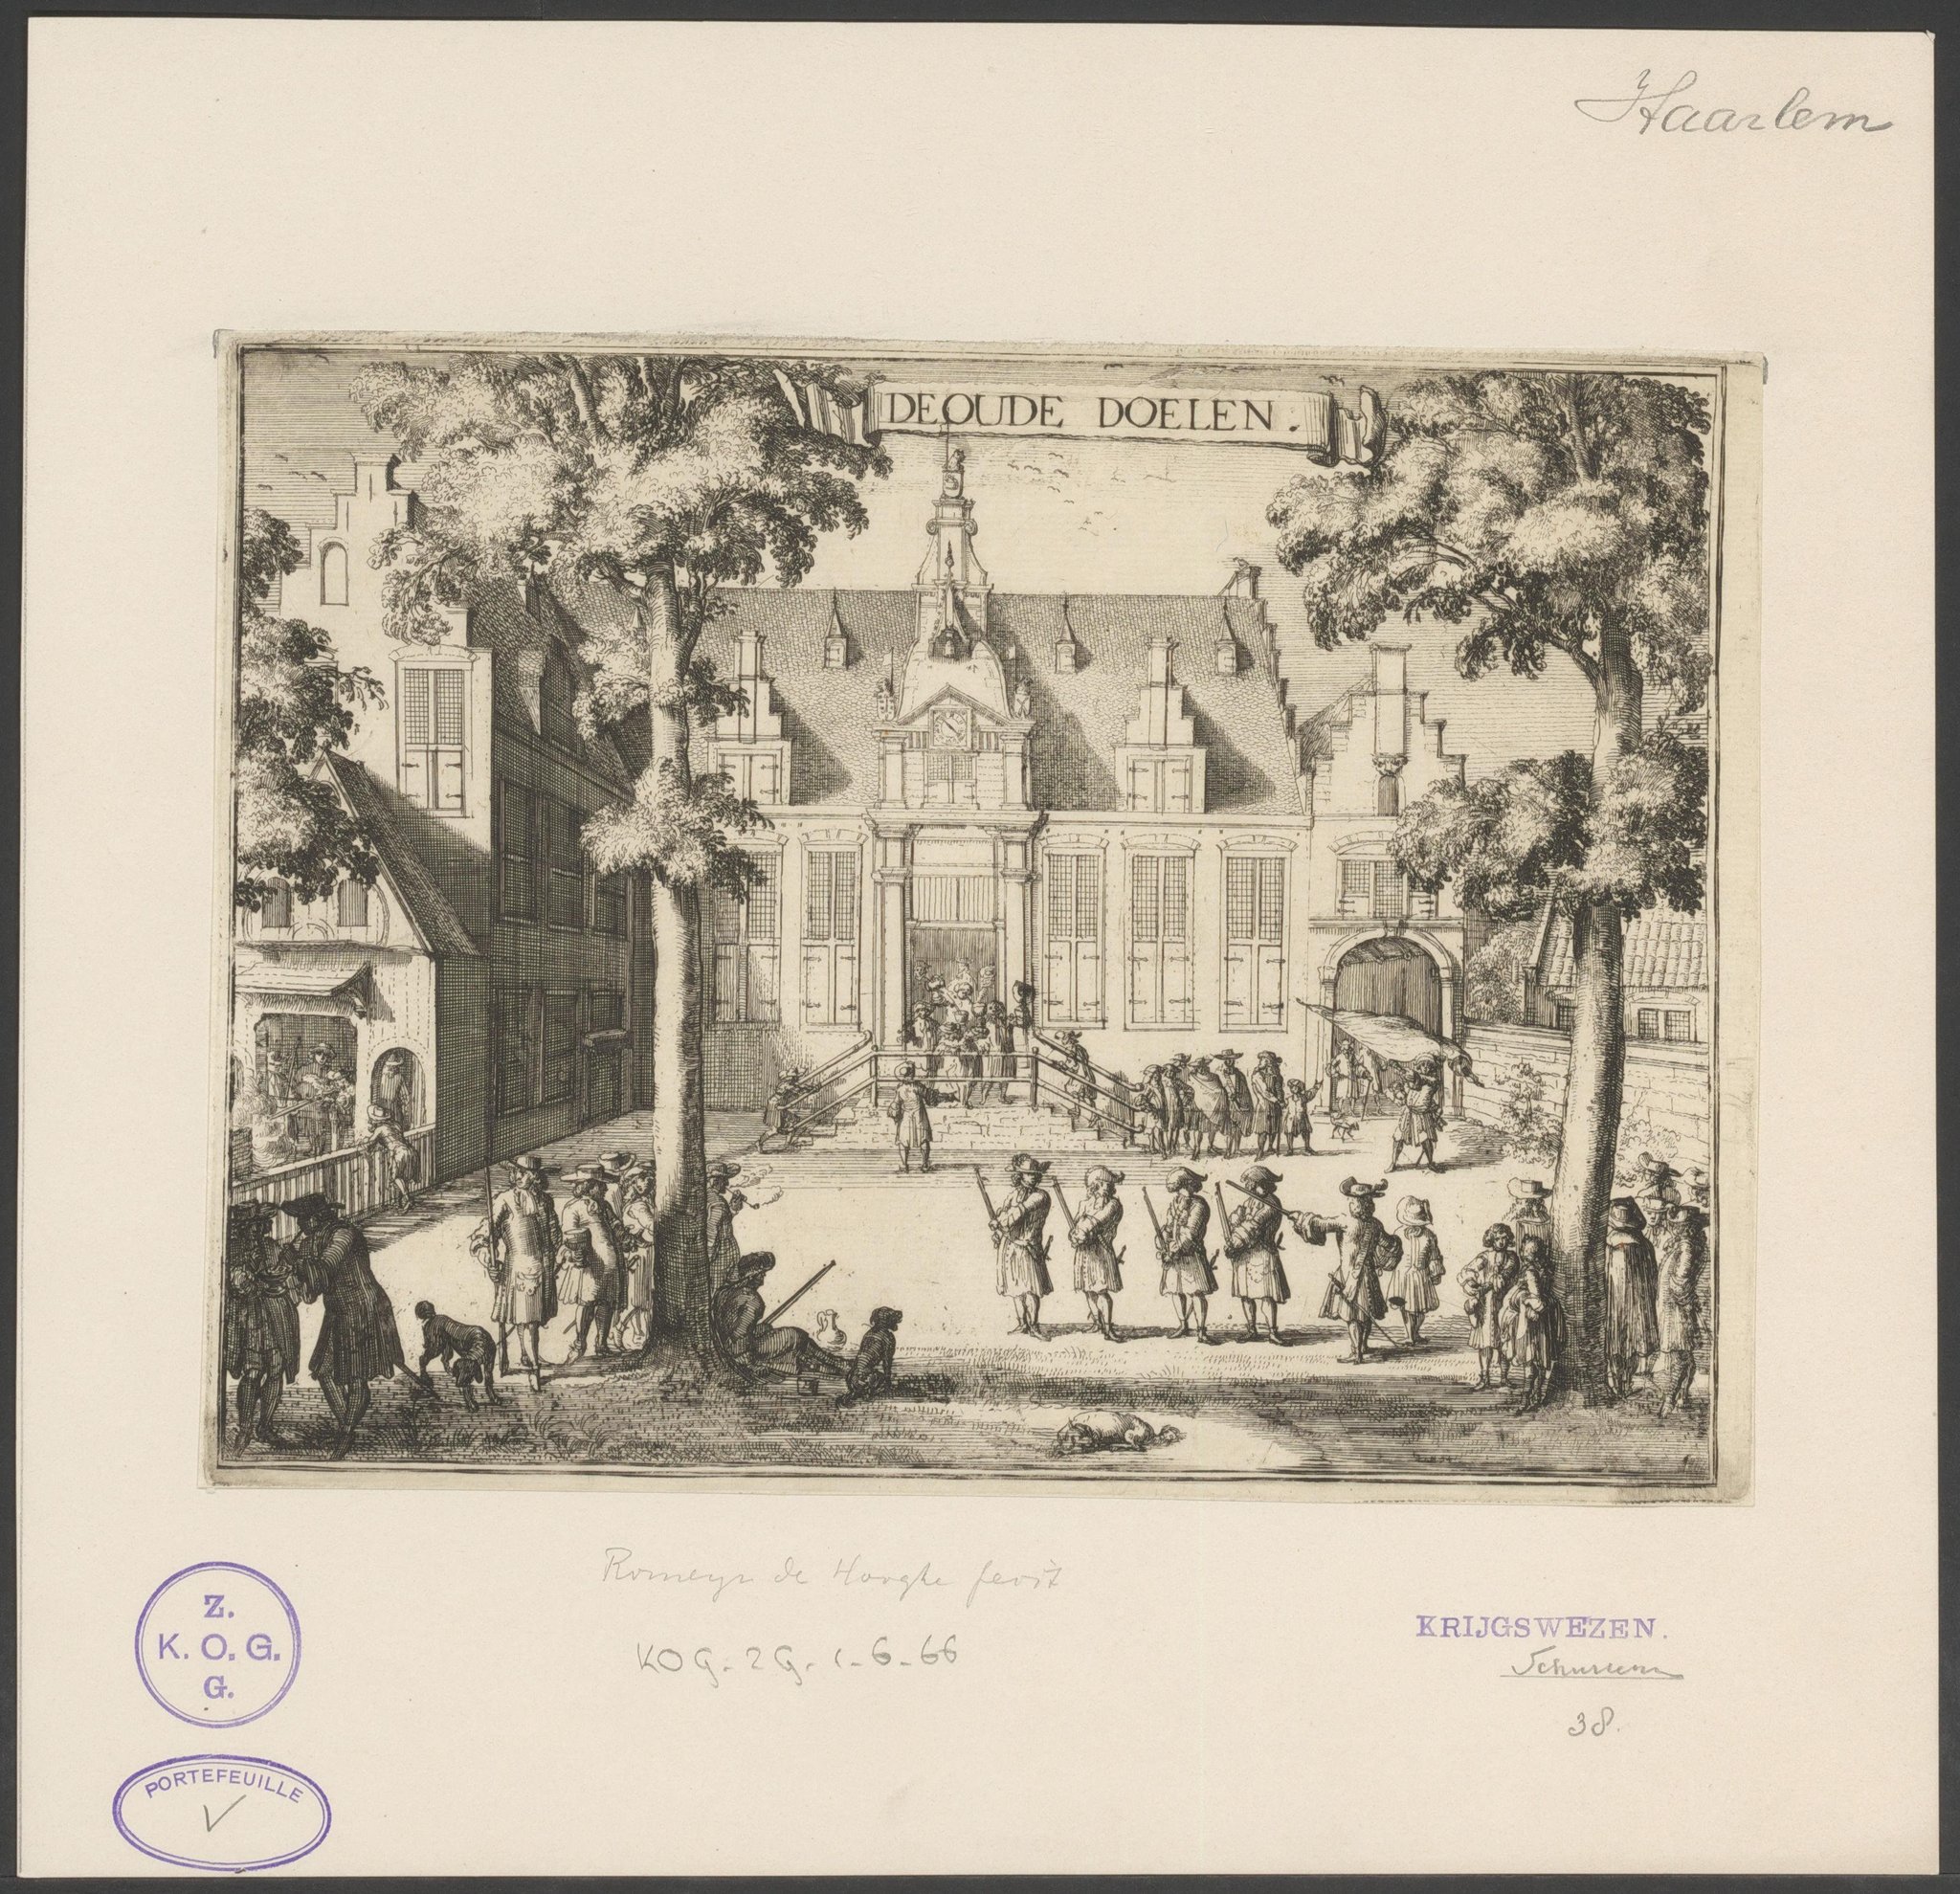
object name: print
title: De Oude Doelen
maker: romeyn de hooghe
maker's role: draughtsman, goldsmith, painter, print maker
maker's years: 1645-1708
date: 1688-1689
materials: paper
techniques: etching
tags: edifice, e.g.: public building, department store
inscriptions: stamp, stamp, collector's mark: Lugt 1641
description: Gezicht op de Oude Doelen (Schuttersdoelen) te Haarlem, met vele schutters op het plein ervoor. Dit blad maakt deel uit van een omvangrijke prent met een grote plattegrond van Haarlem, omgeven door zeven wapenschilden, een profiel van de stad, gezichten op markante Haarlemse gebouwen en voorstellingen van belangrijke momenten uit de Haarlemse geschiedenis. Onderwerpsrubrieken binnen de Atlas Zeden en Gewoonten: Krijgswezen, Schutterij, Doelens.